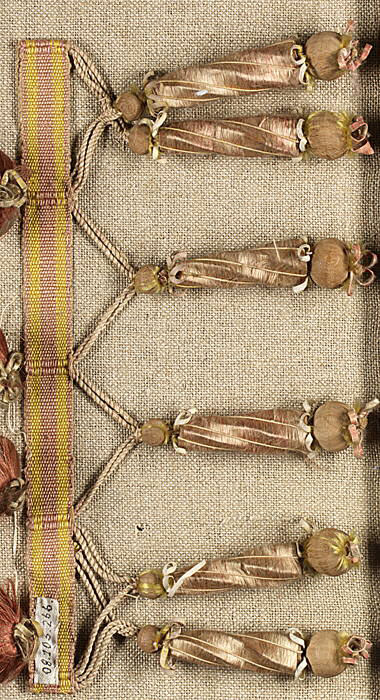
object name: fringe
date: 1801-1900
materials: cotton, silk